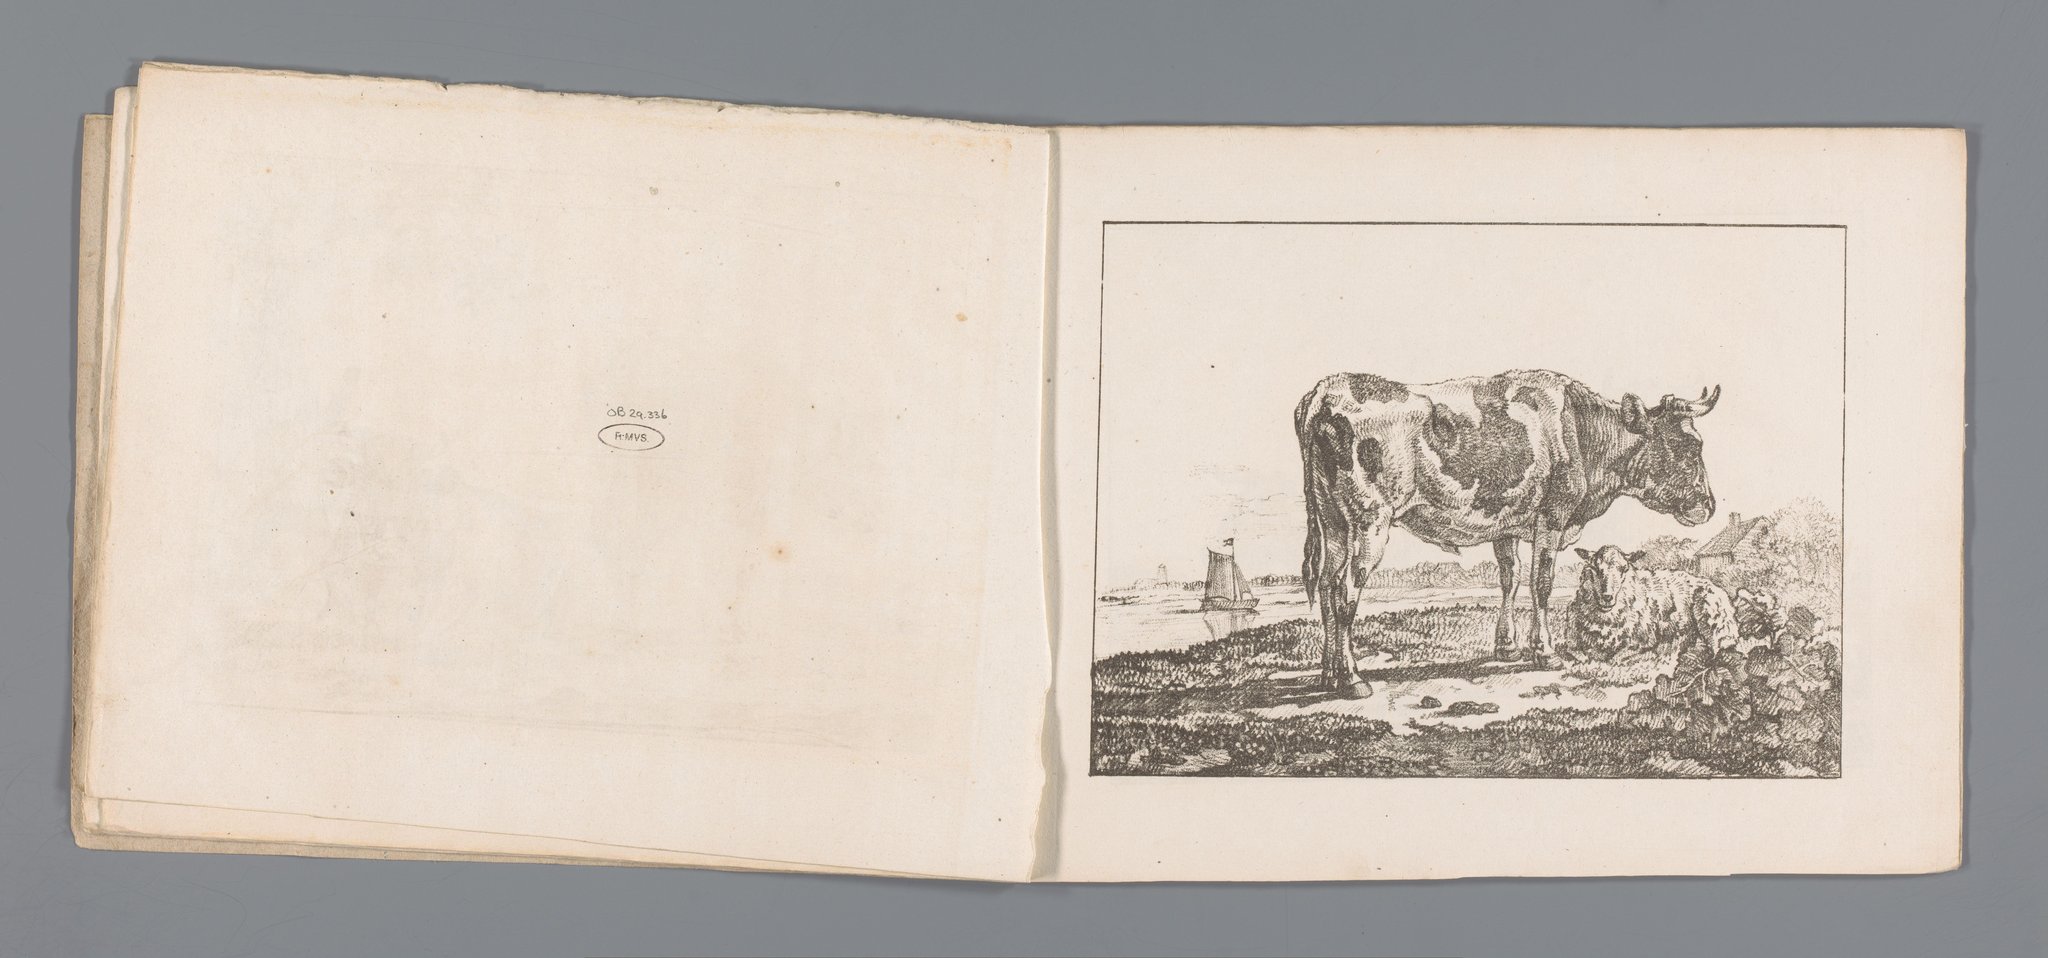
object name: album leaf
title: Os en schaap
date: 1818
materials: paper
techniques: lithograph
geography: rotterdam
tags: sheep, ox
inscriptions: collector's mark: Lugt 2228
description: Prent vijf uit een serie van acht. Jan Kobell (III) is mogelijk de prentmaker van prent twee, vier, vijf en acht van de serie. Zie Moulijn, 1927.